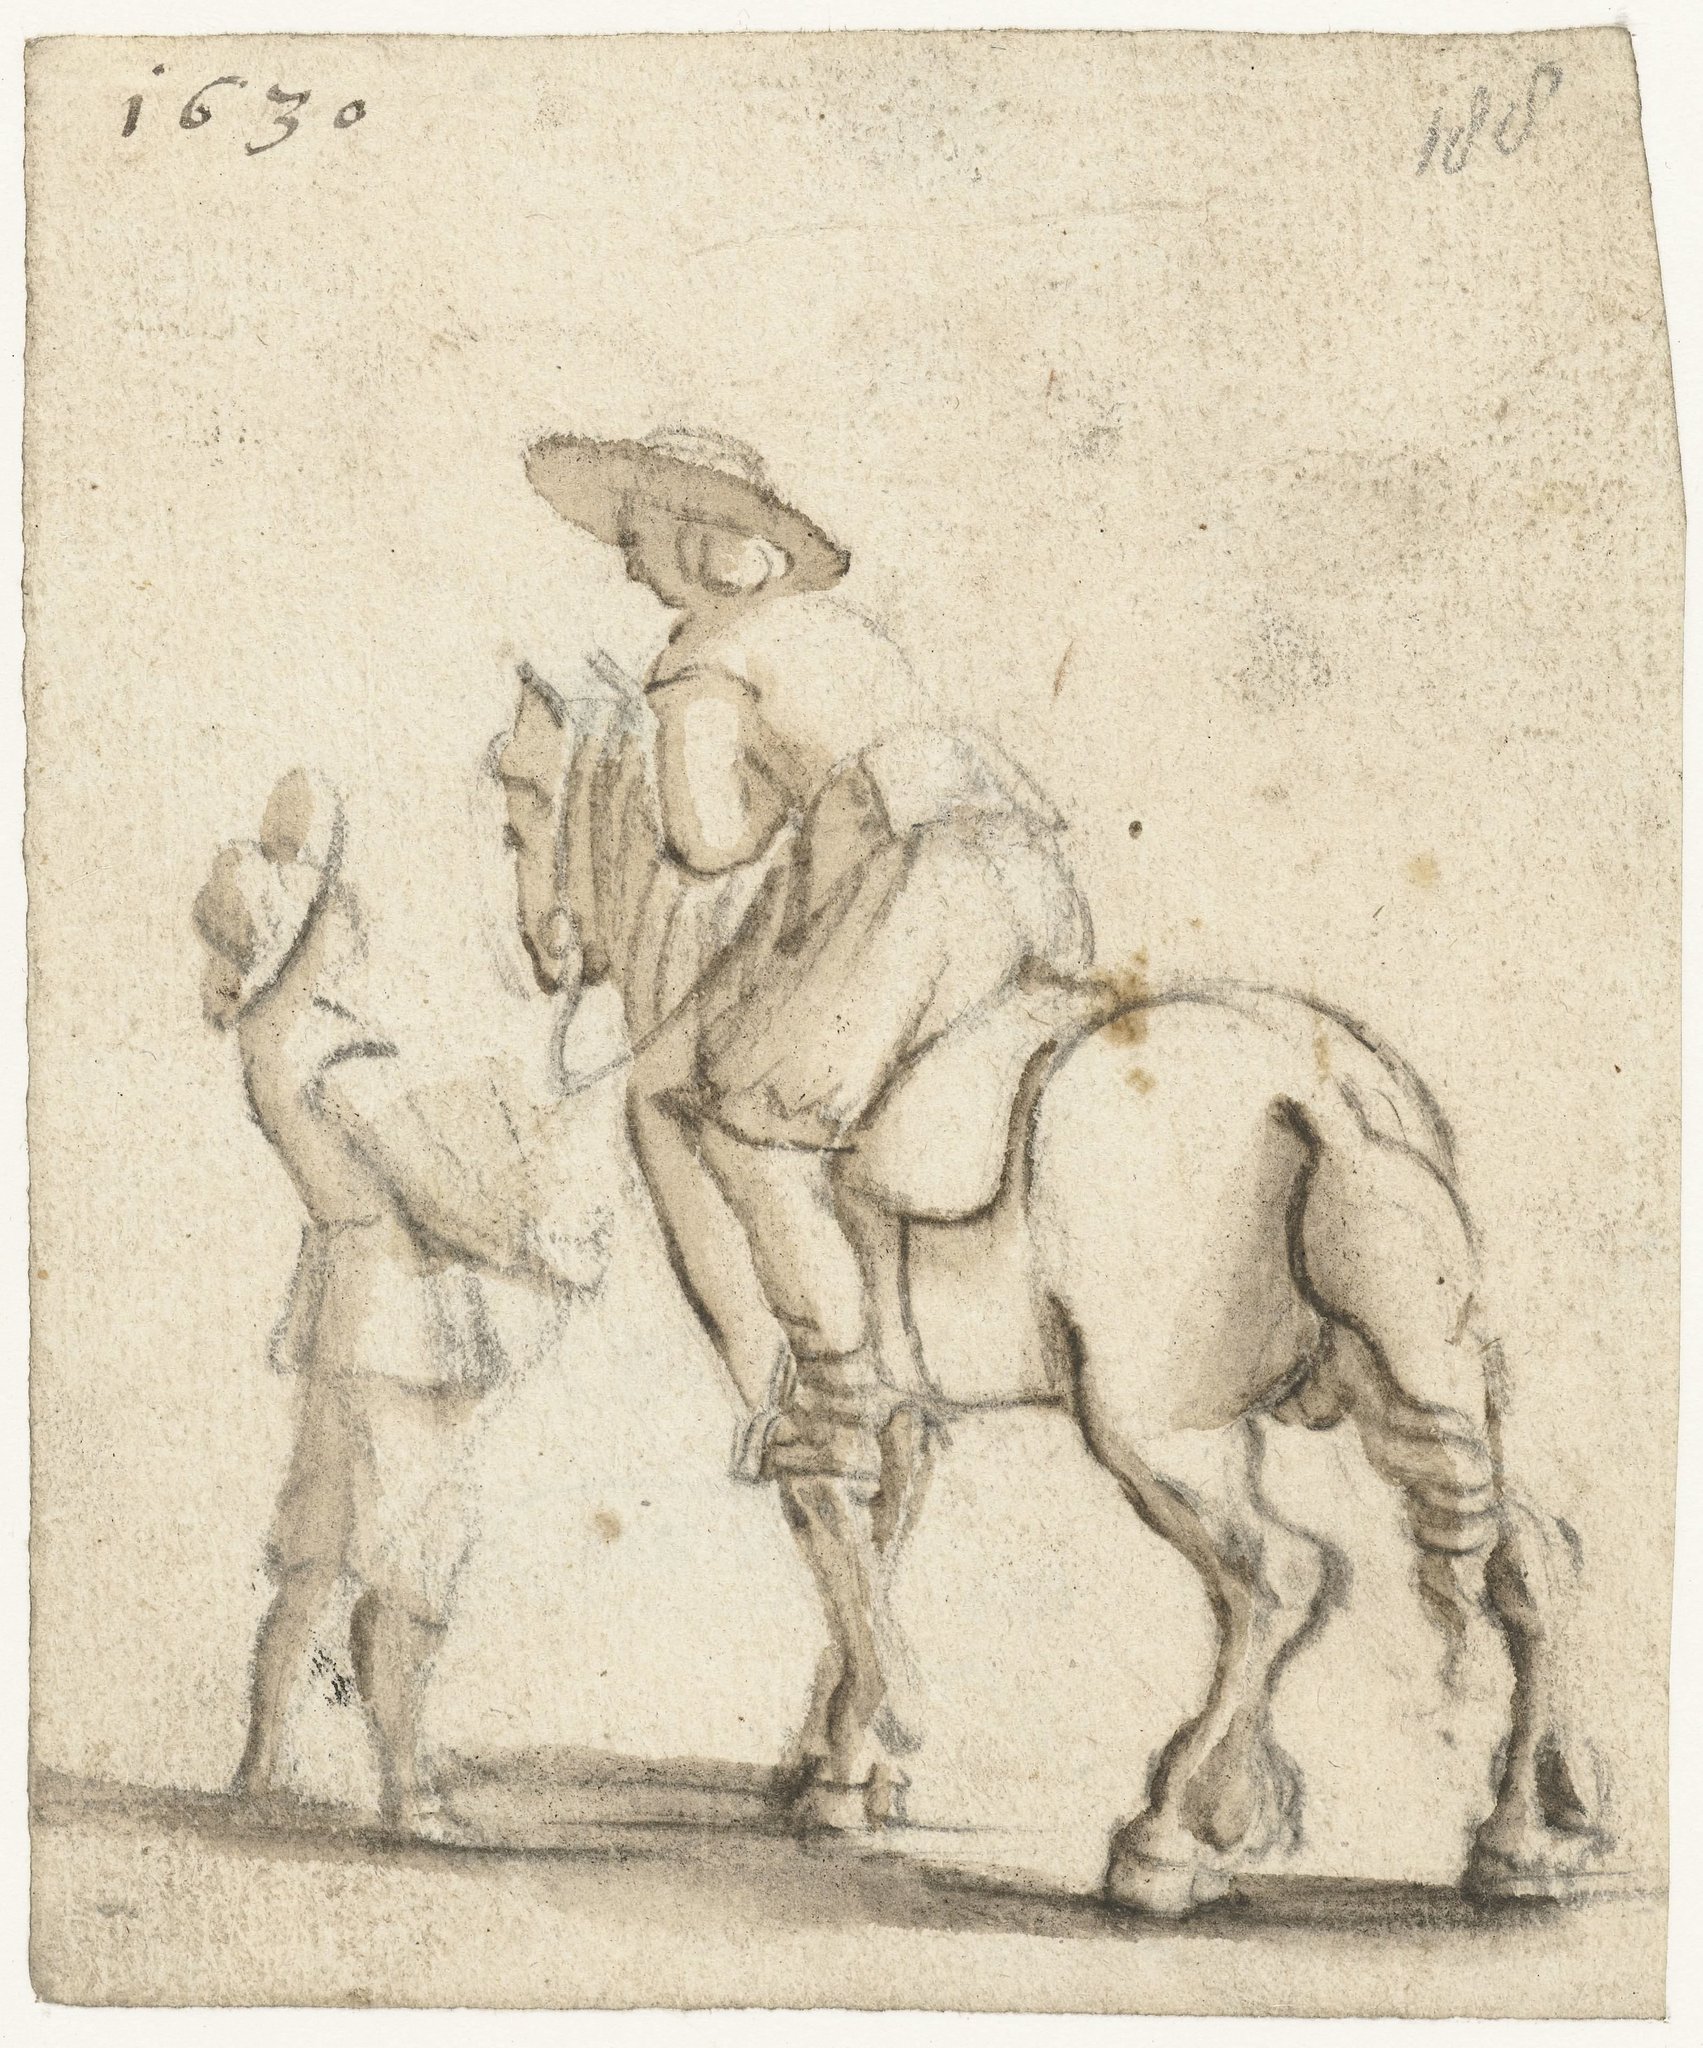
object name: drawing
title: Ruiter te paard pratend met een jongetje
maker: gerard ter borch (ii)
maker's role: draughtsman, painter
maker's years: 1617-1681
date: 1630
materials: chalk, ink, paper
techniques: brush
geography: zwolle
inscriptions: date: ‘1630’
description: Ruiter te paard pratend met een jongetje dat naast het paard staat met een groot pak in zijn armen.